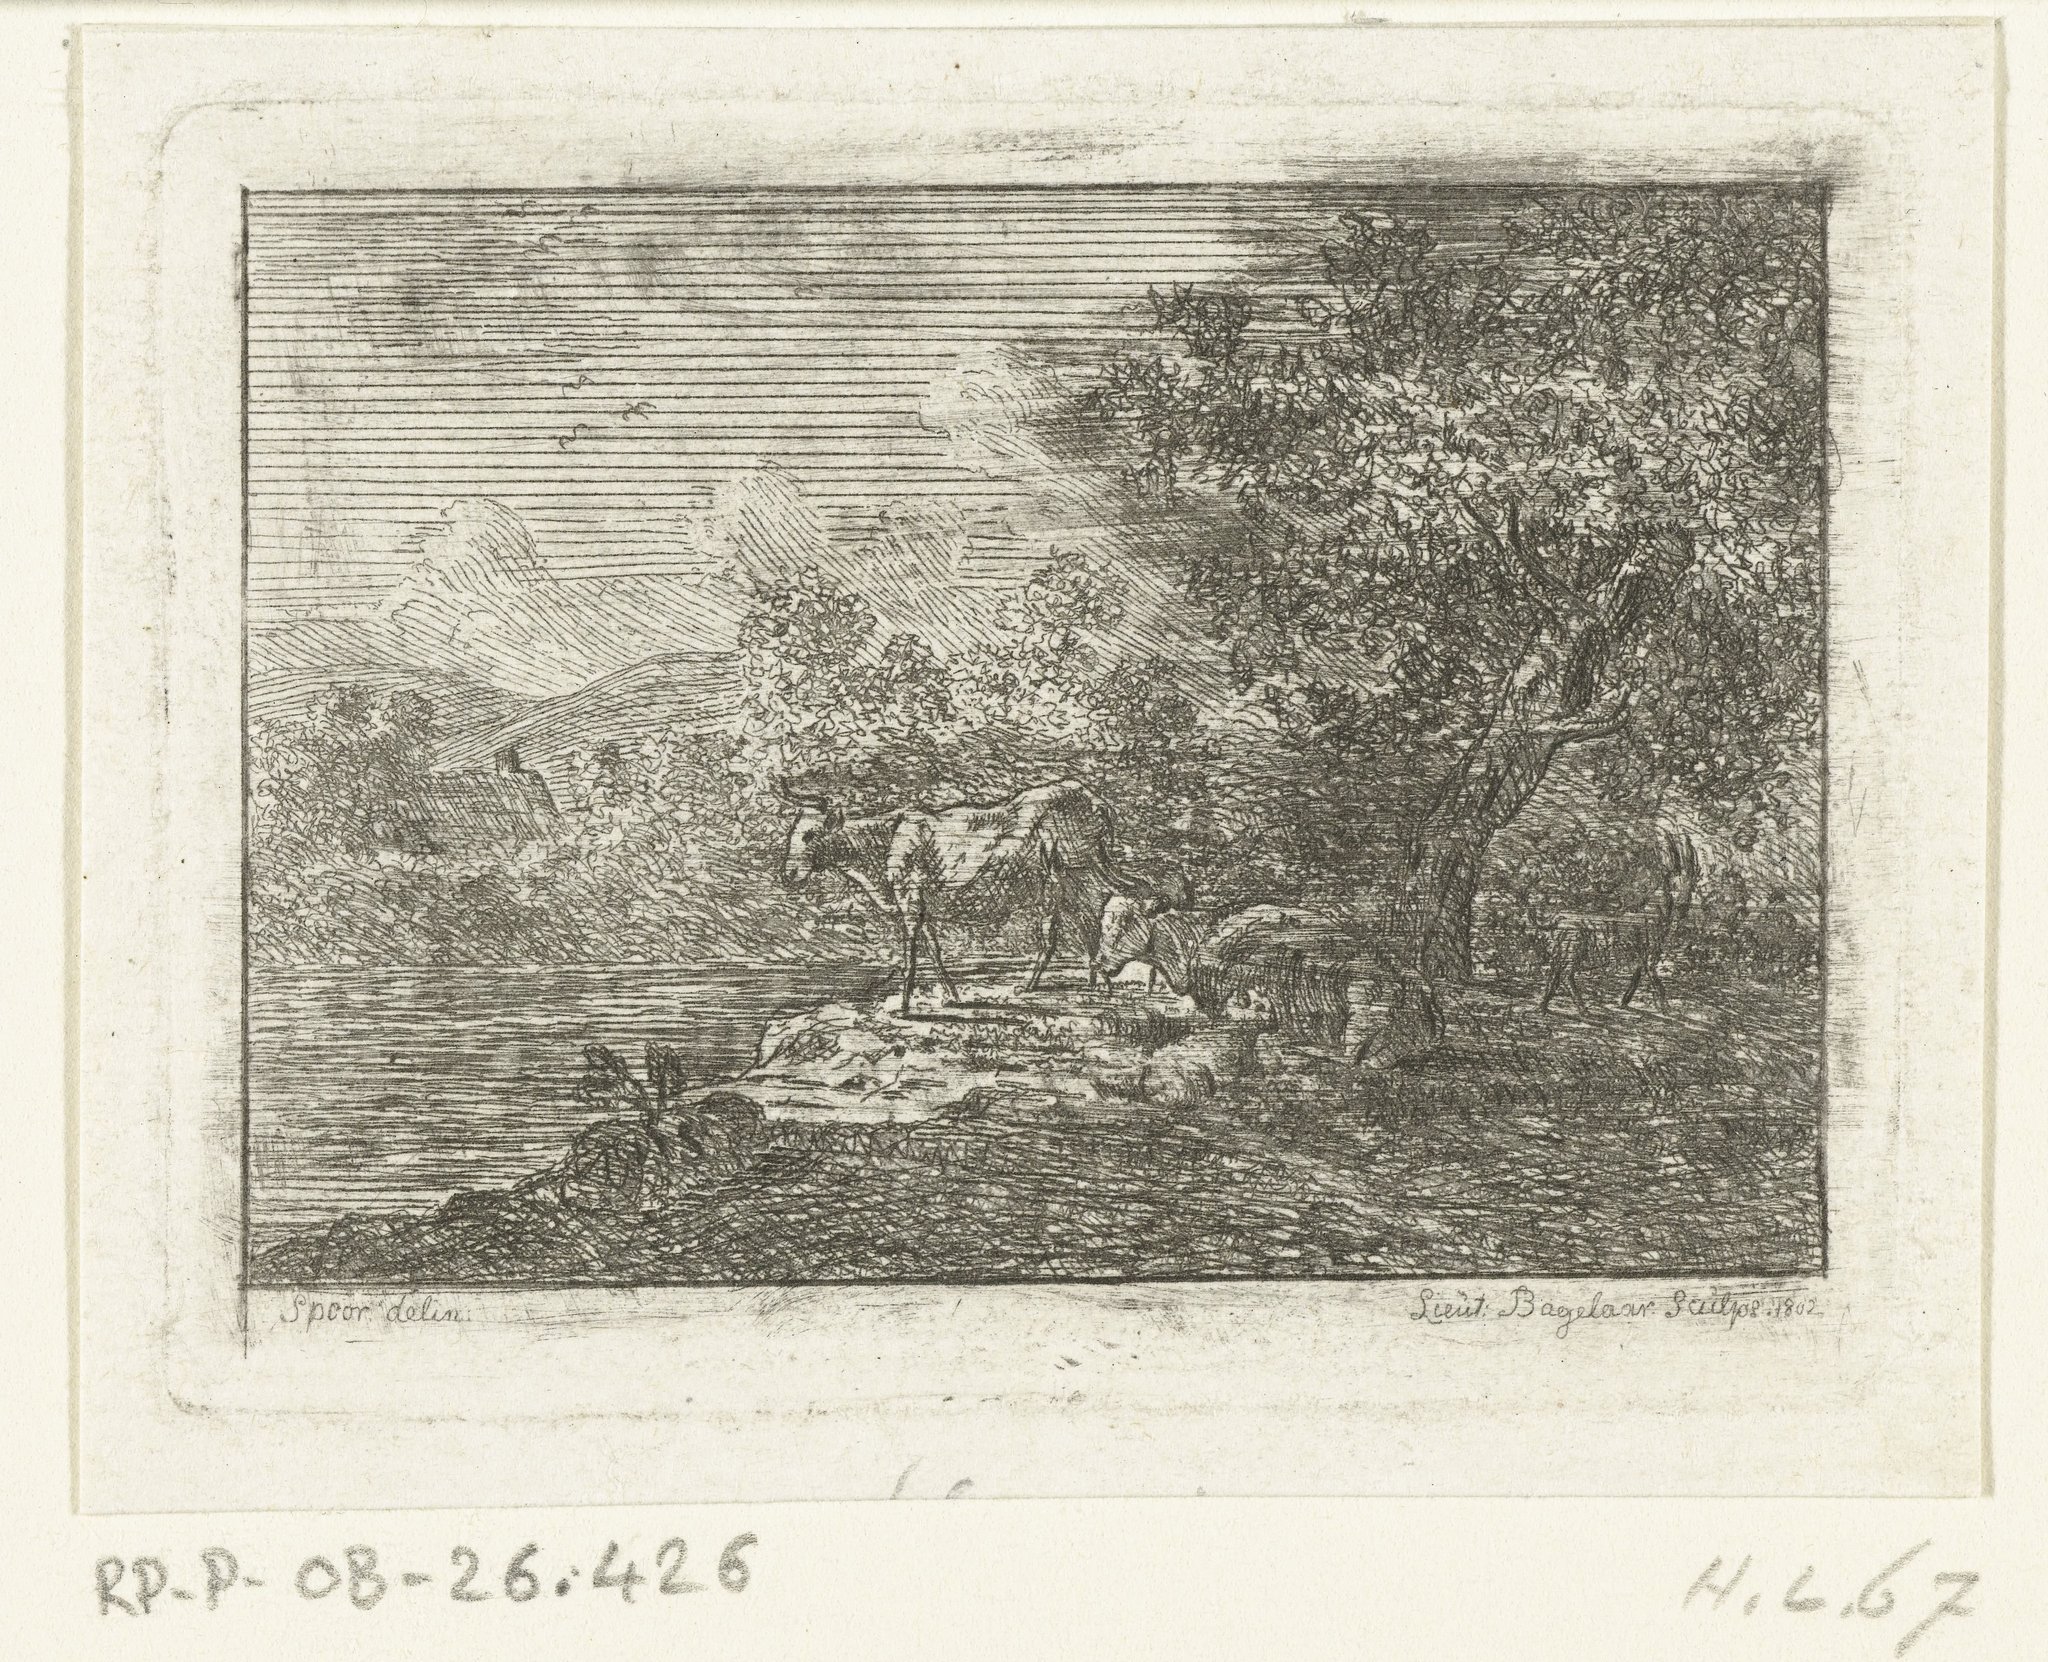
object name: print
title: Rivierlandschap met dieren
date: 1802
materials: paper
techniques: drypoint, etching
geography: netherlands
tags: landscapes with waters, waterscapes, seascapes (in the temperate zone)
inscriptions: date